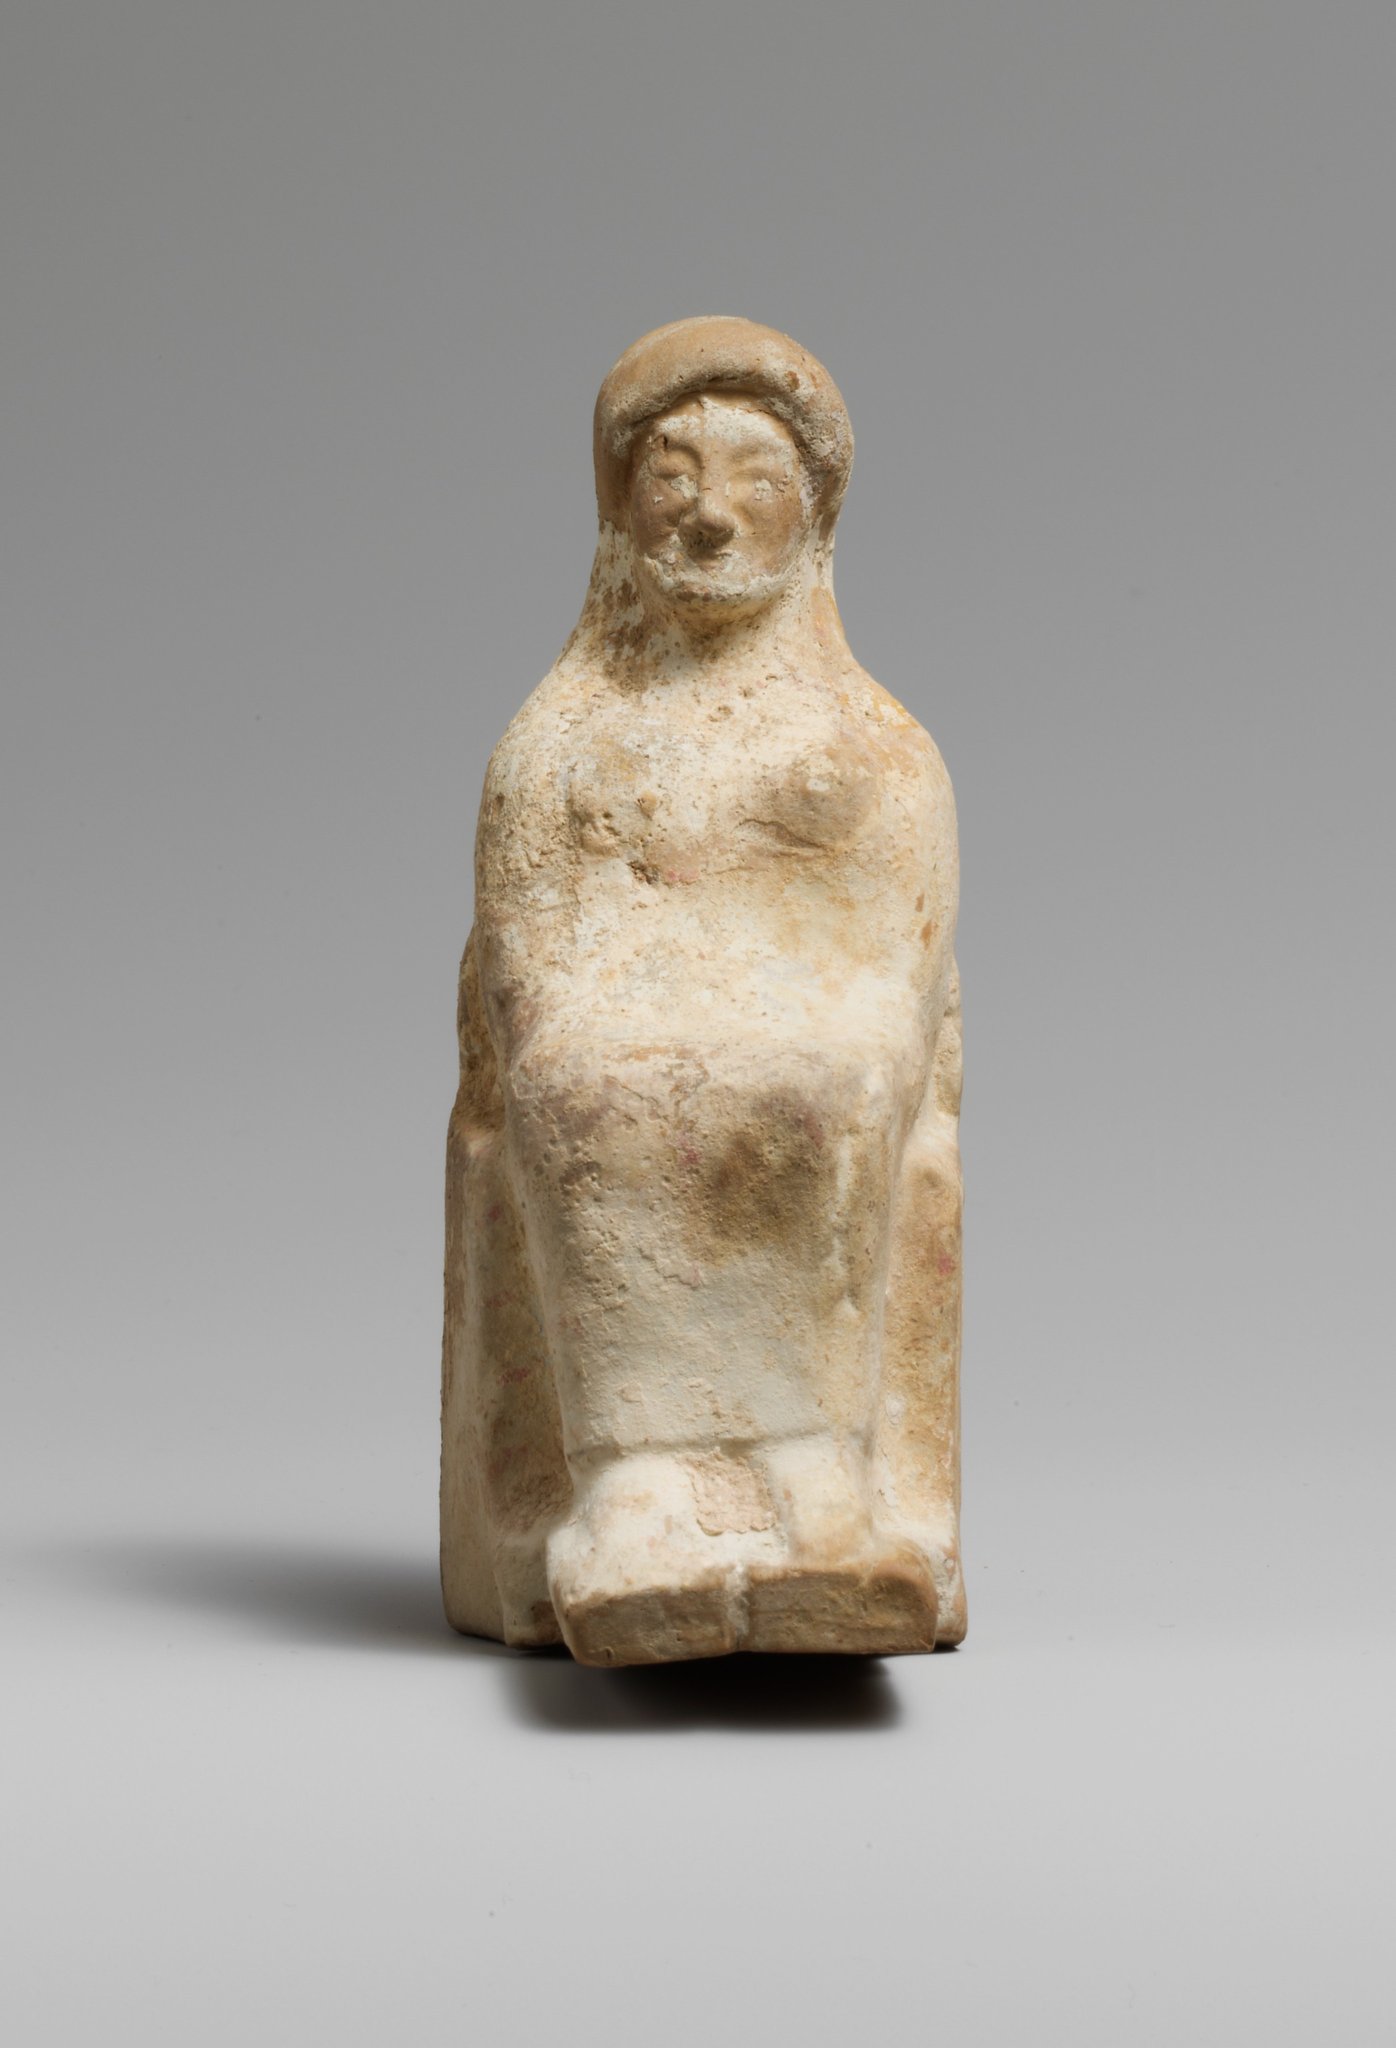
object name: statuette of a seated goddess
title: Terracotta statuette of a seated woman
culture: east greek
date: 500-401 BCE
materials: terracotta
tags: women